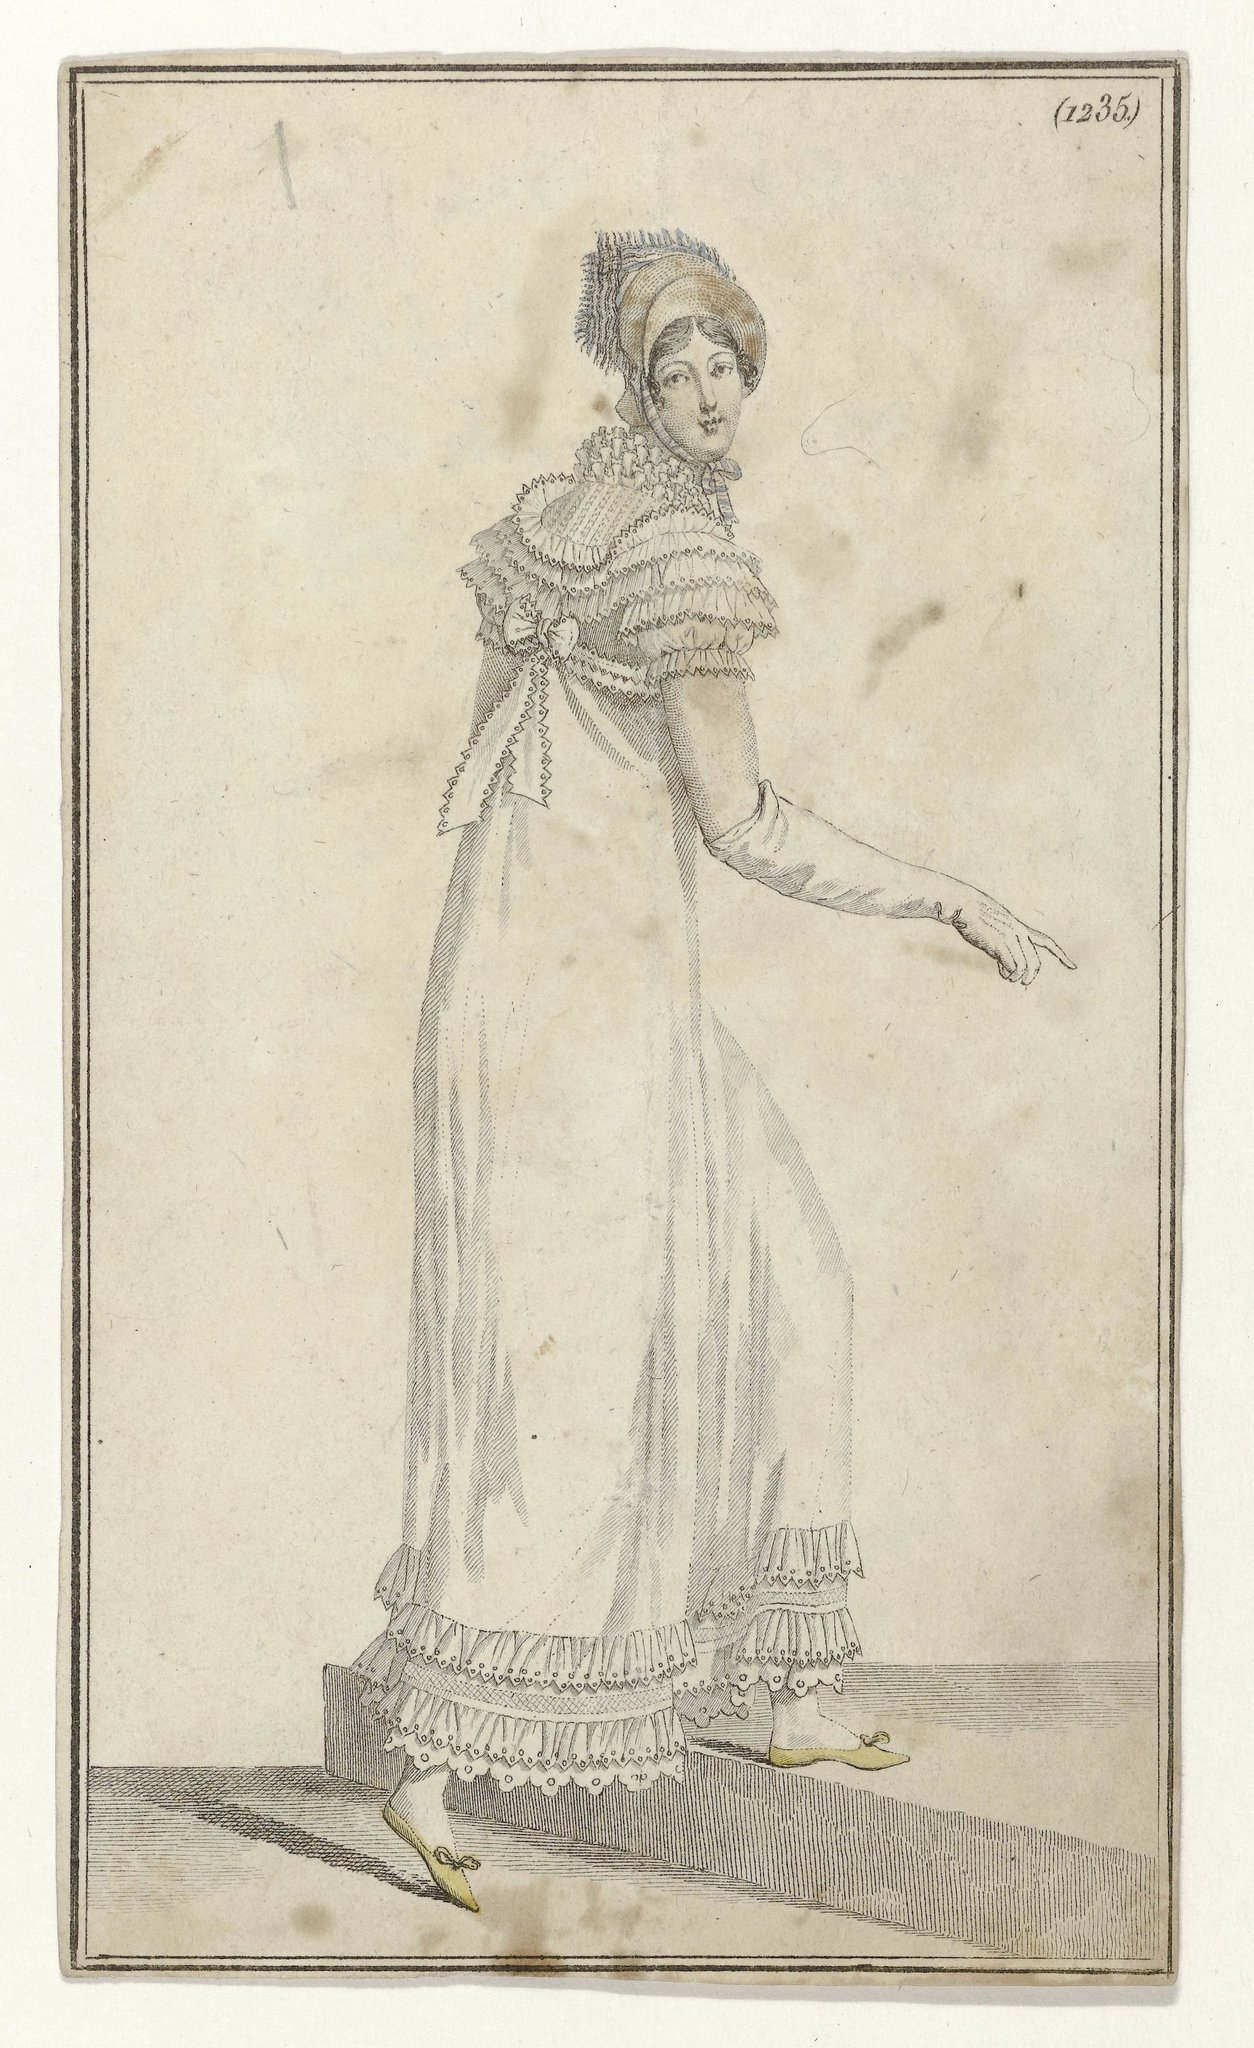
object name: fashion print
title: Journal des Dames et des Modes, Costume Parisien, 15 juin 1812, (1235): Chapeau de paill (...)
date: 1812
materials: paper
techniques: engraving, hand coloring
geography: paris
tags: gloves, mittens (long gloves) (+ women's clothes), fashion plates, head-gear: hat (+ women's clothes), shoes, sandals (+ women's clothes), dress, gown (+ women's clothes), belt, girdle, waistband (+ women's clothes)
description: Vrouw, op de rug gezien, lopend naar rechts, met op het hoofd een hoed van 'paille d'Italie'. Zij draagt een japon met korte pofmouwen en garnering van 'mousseline claire'. Verdere accessoires: ceintuur(?) op de rug gestrikt, lange handschoen, platte schoenen met puntige neuzen en strikken. De prent maakt deel uit van het modetijdschrift Journal des Dames et des Modes, uitgegeven door Pierre de la Mésangère, Parijs, 1797-1839.